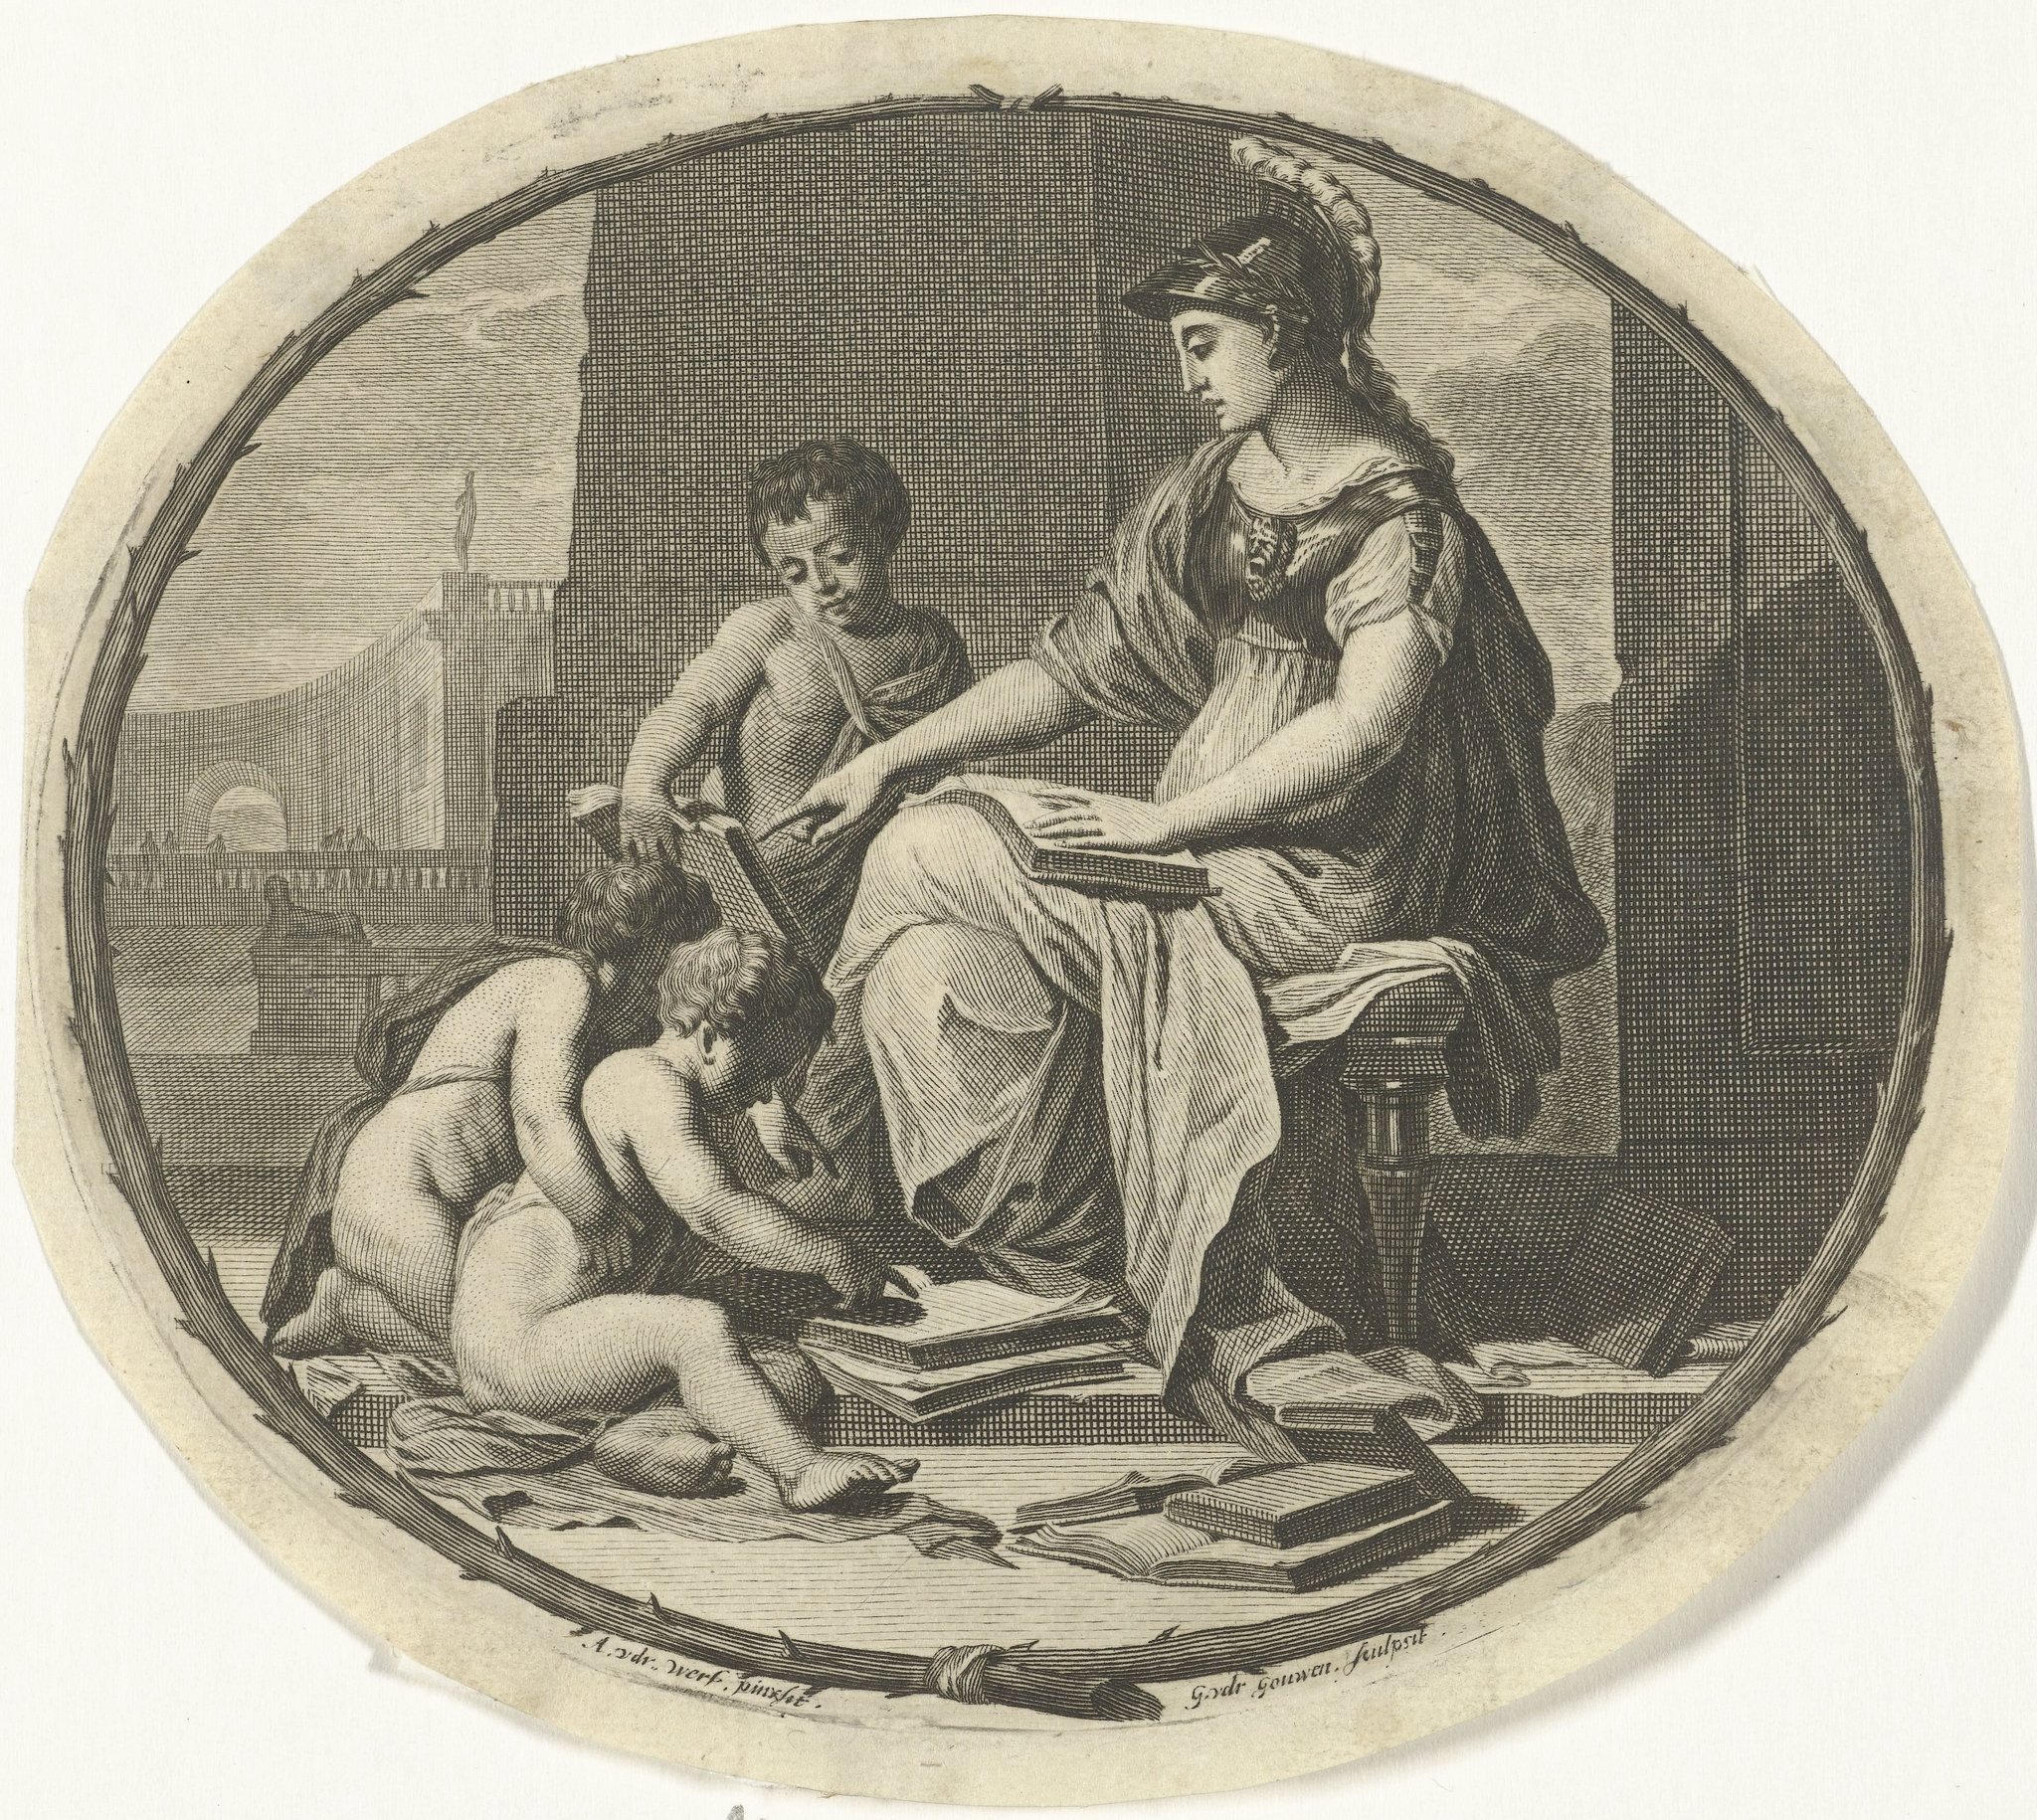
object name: print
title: Minerva geeft les aan enkele putti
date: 1670-1740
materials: paper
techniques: engraving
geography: amsterdam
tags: (story of) minerva (pallas, athena), cupids: 'amores', 'amoretti', 'putti'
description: Voorstelling in een ovaal. Minerva zit op een stoel. Op haar schoot een boek. Ze onderwijst enkele putti die rondom haar staan en zitten. Op de achtergrond Romeinse architectuur.